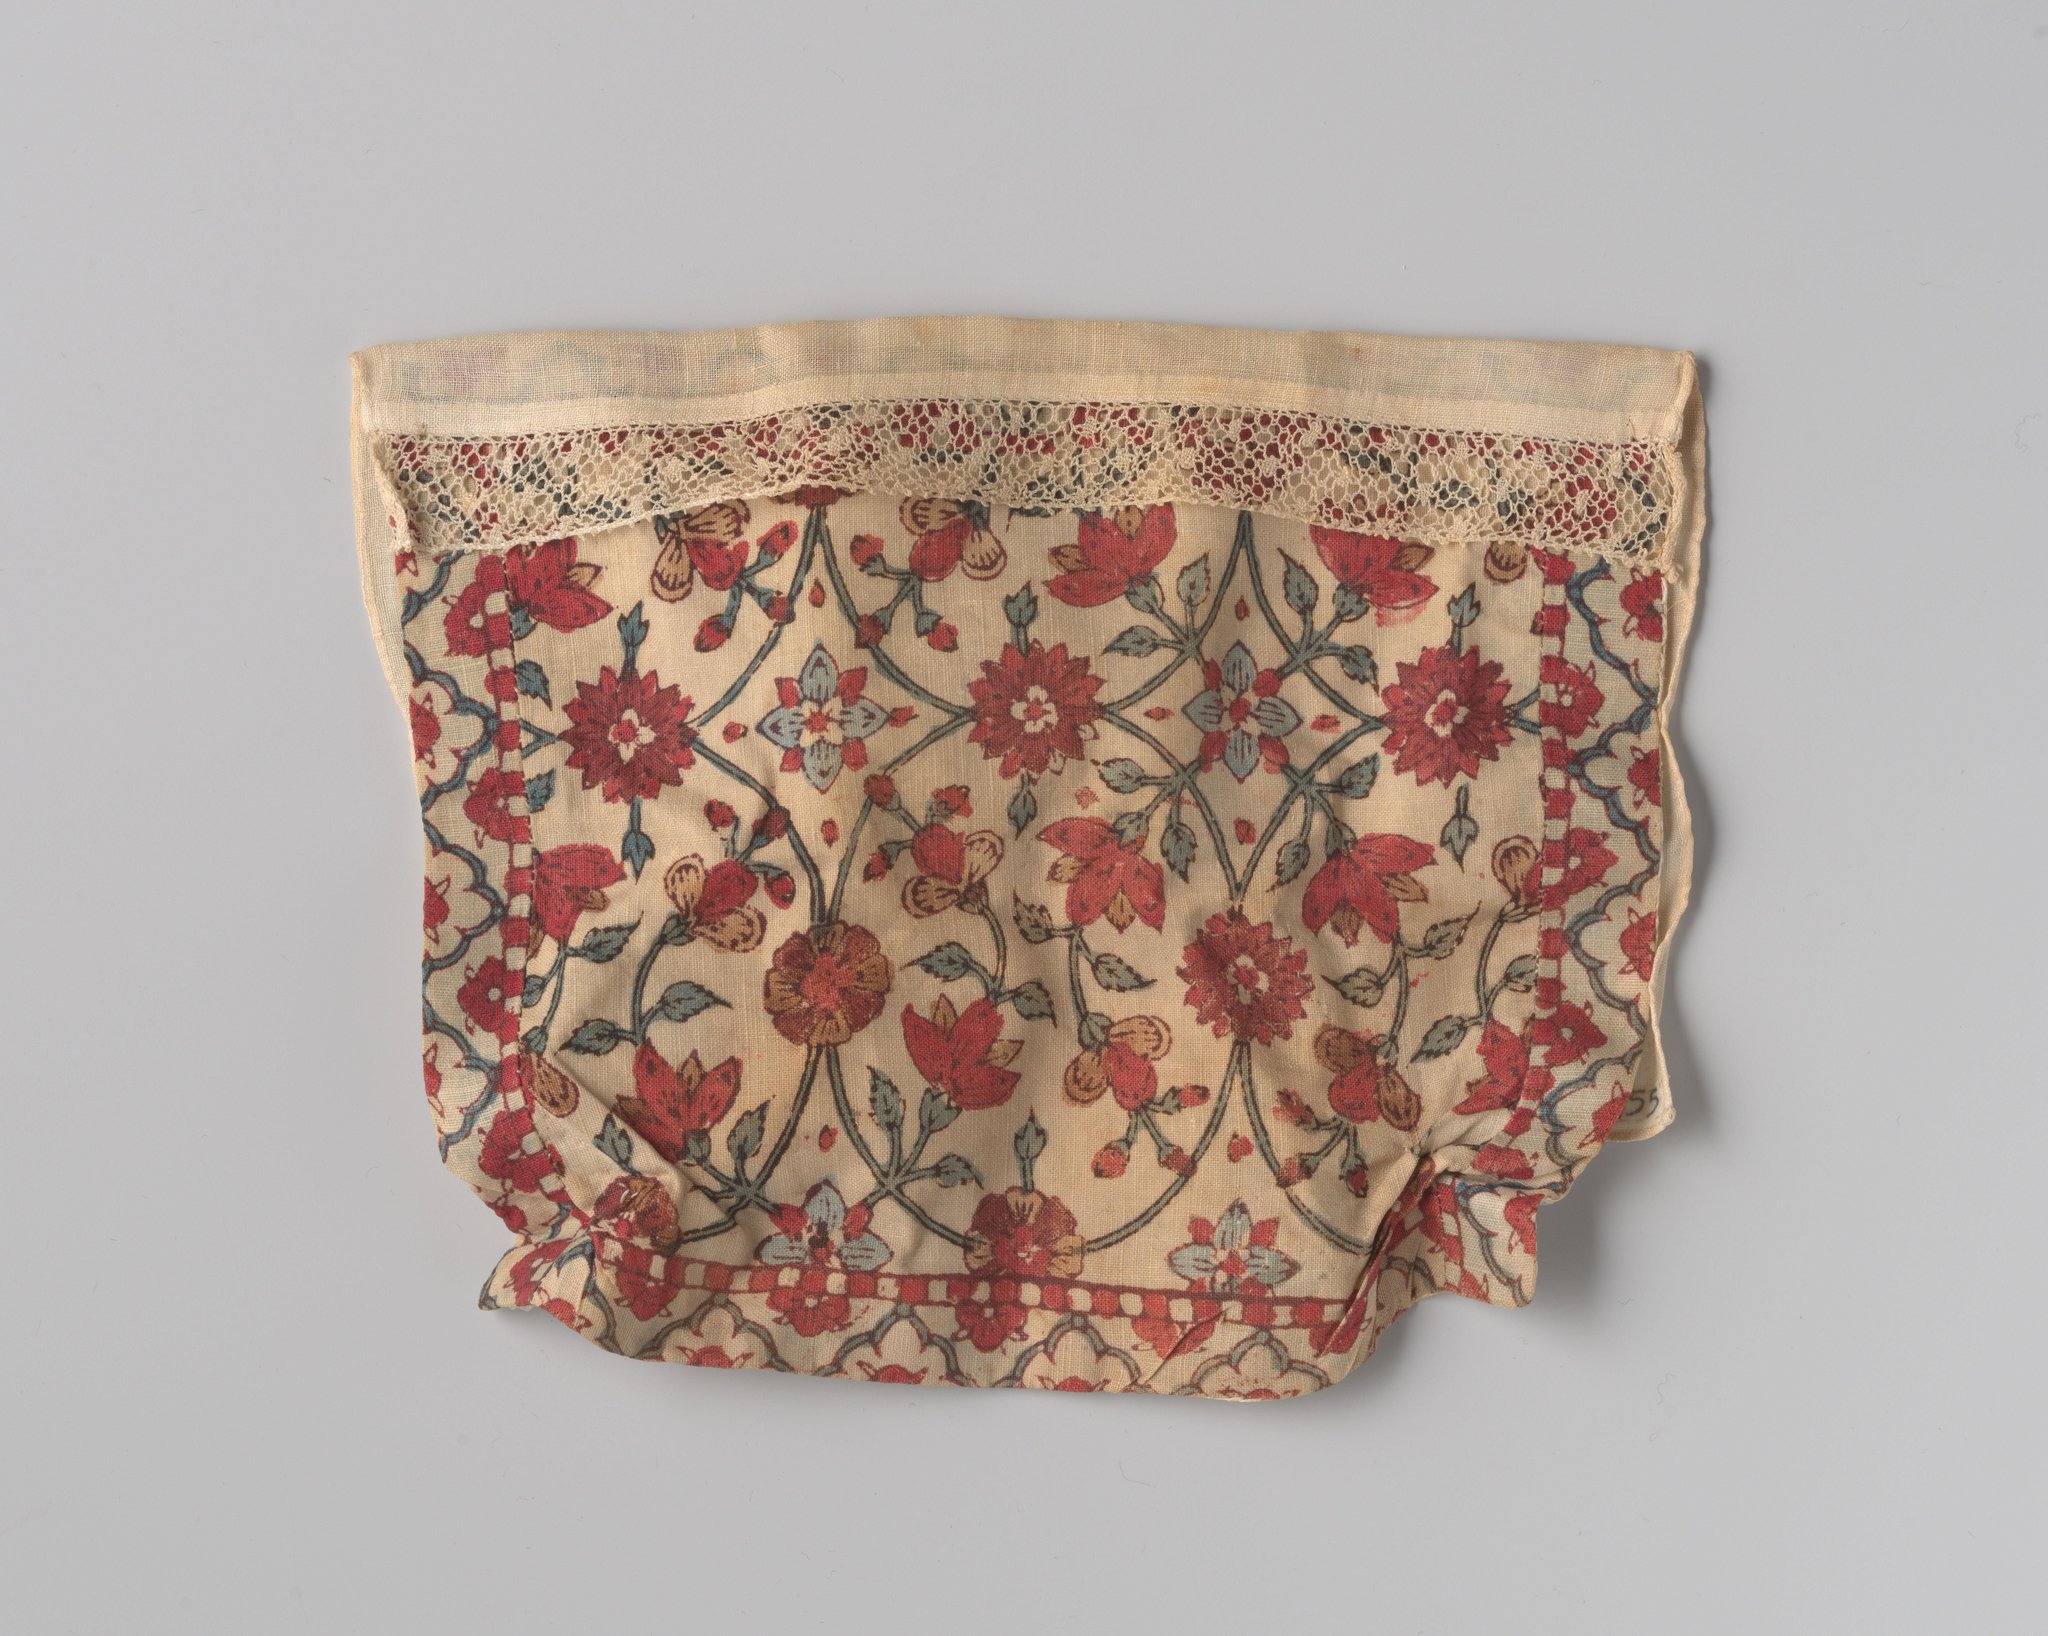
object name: miniature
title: Laken voor wieg, van fijn linnen (batist), met aangezette strook kloskant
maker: Anonymous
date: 1690-1710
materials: linen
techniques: lace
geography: northern netherlands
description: Laken voor wieg, van zeer fijn linnen (batist), aan drie zijden smalle zoompjes, aan hoofdeinde brede zoom met aangezette strook kloskant. Vastgenaaid aan sprei.